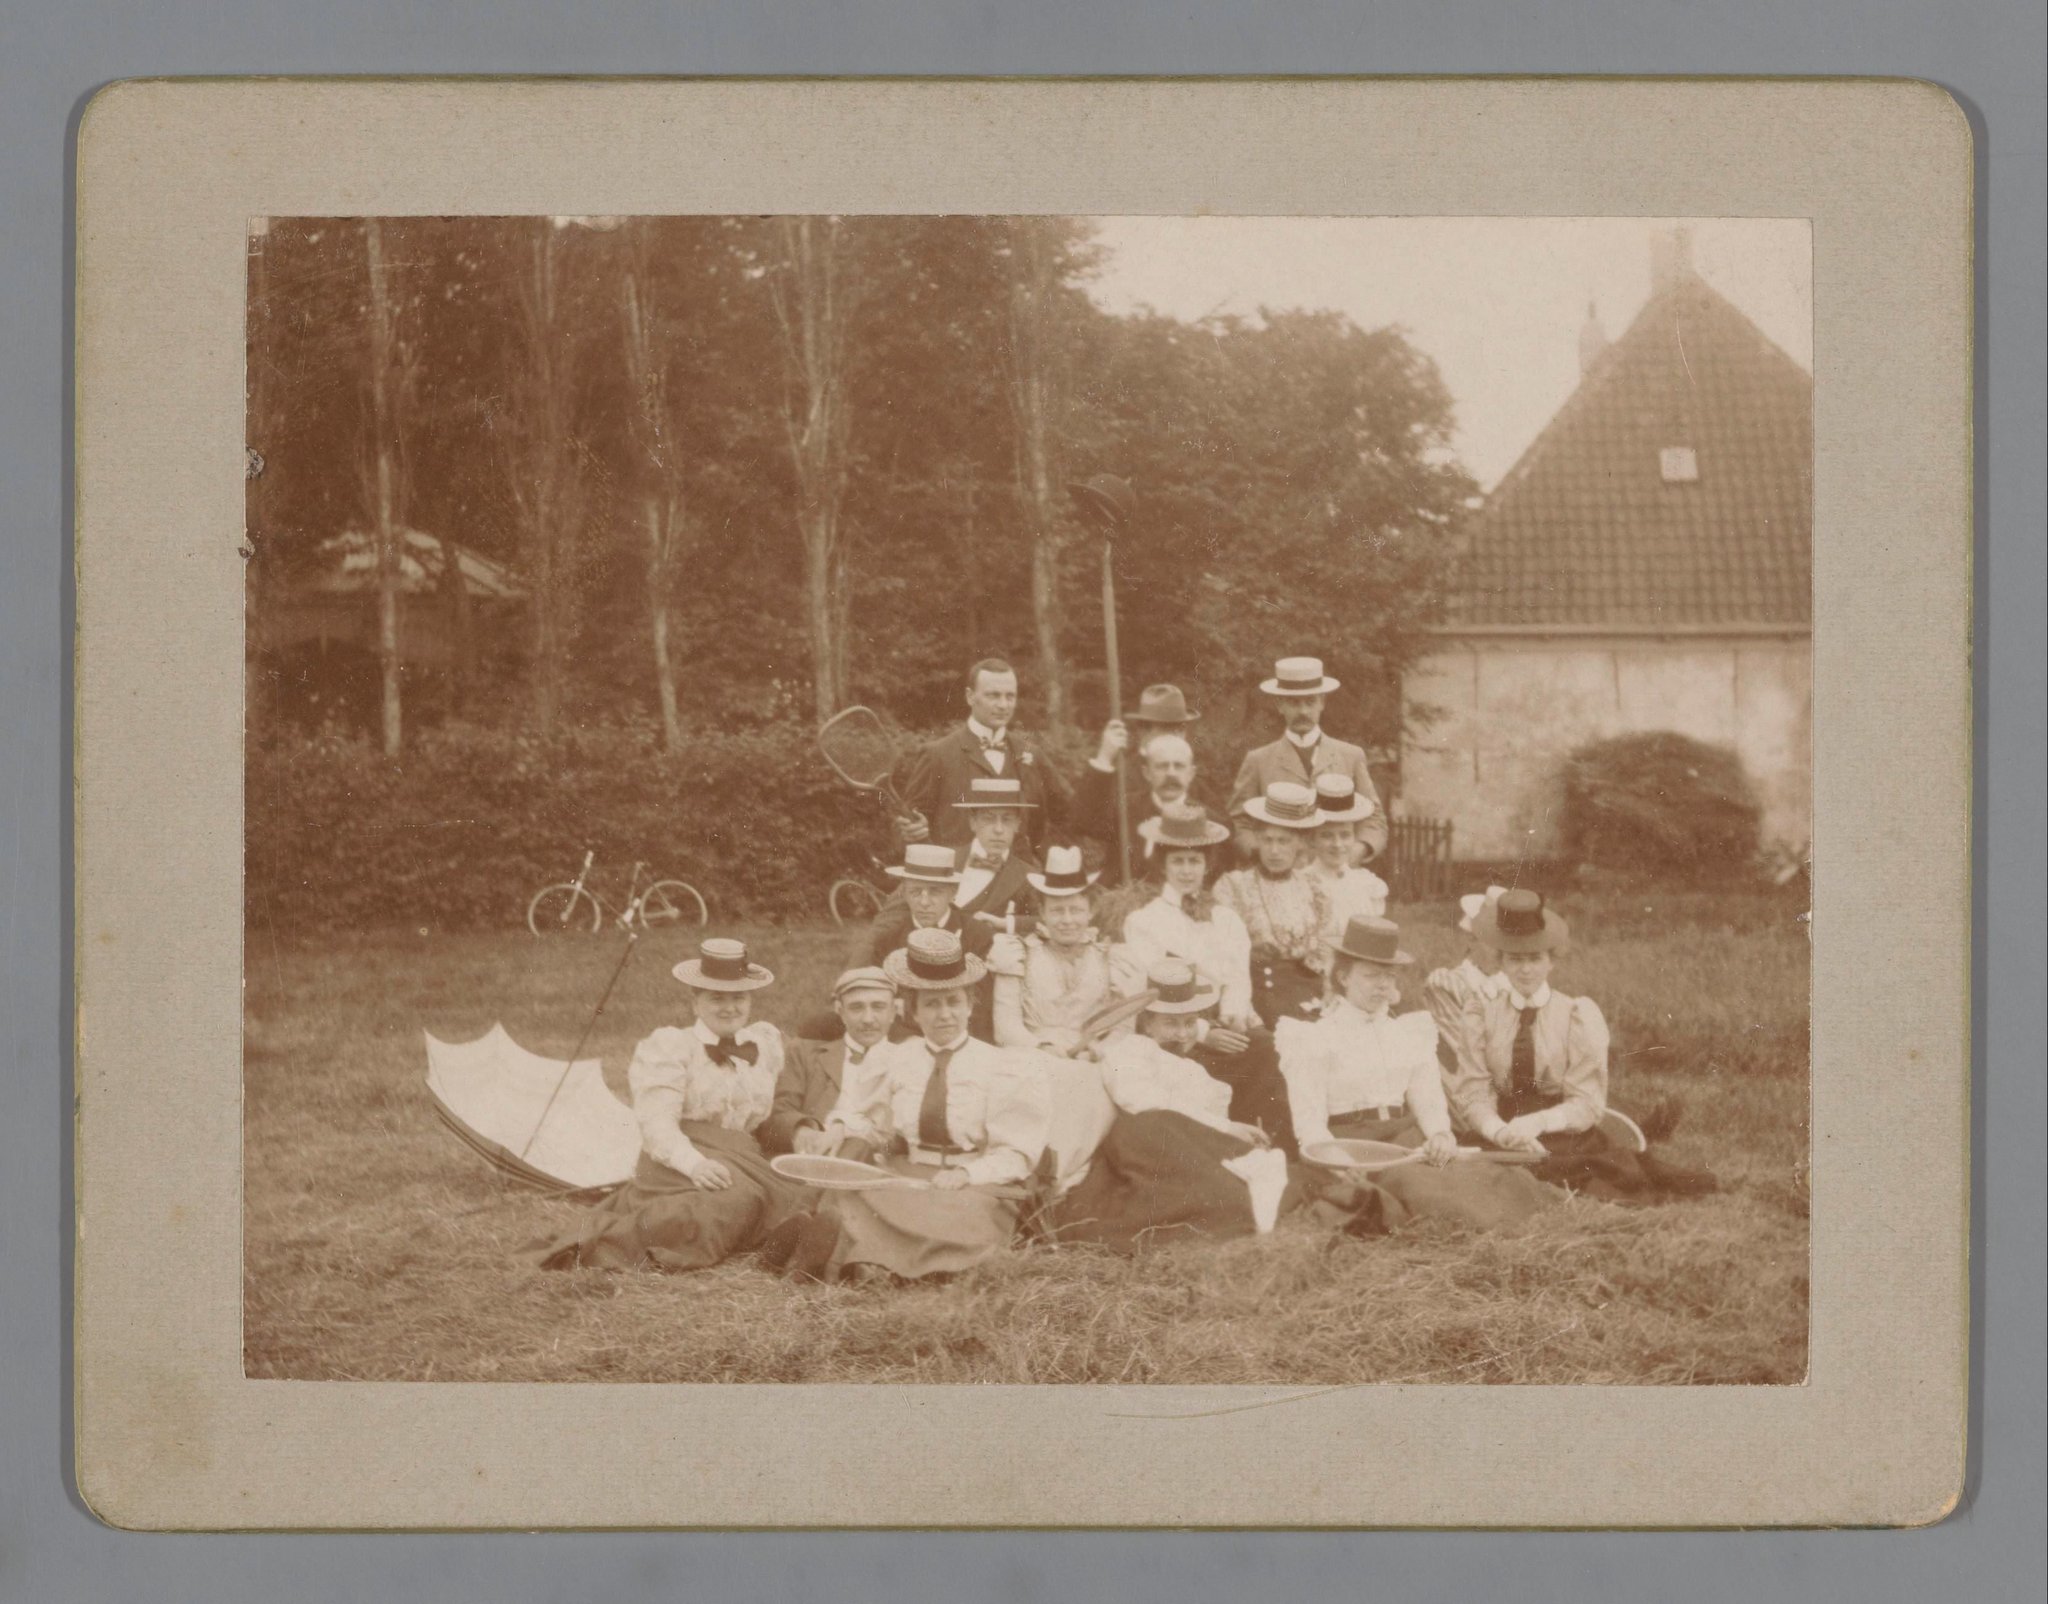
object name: photograph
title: Groepsportret van een onbekende gezelschap met tennisrackets in een weiland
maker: Anonymous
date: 1890-1910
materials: cardboard, photographic support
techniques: collodion silver print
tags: tennis, lawn-tennis, anonymous historical persons portrayed in a group, in a group-portrait